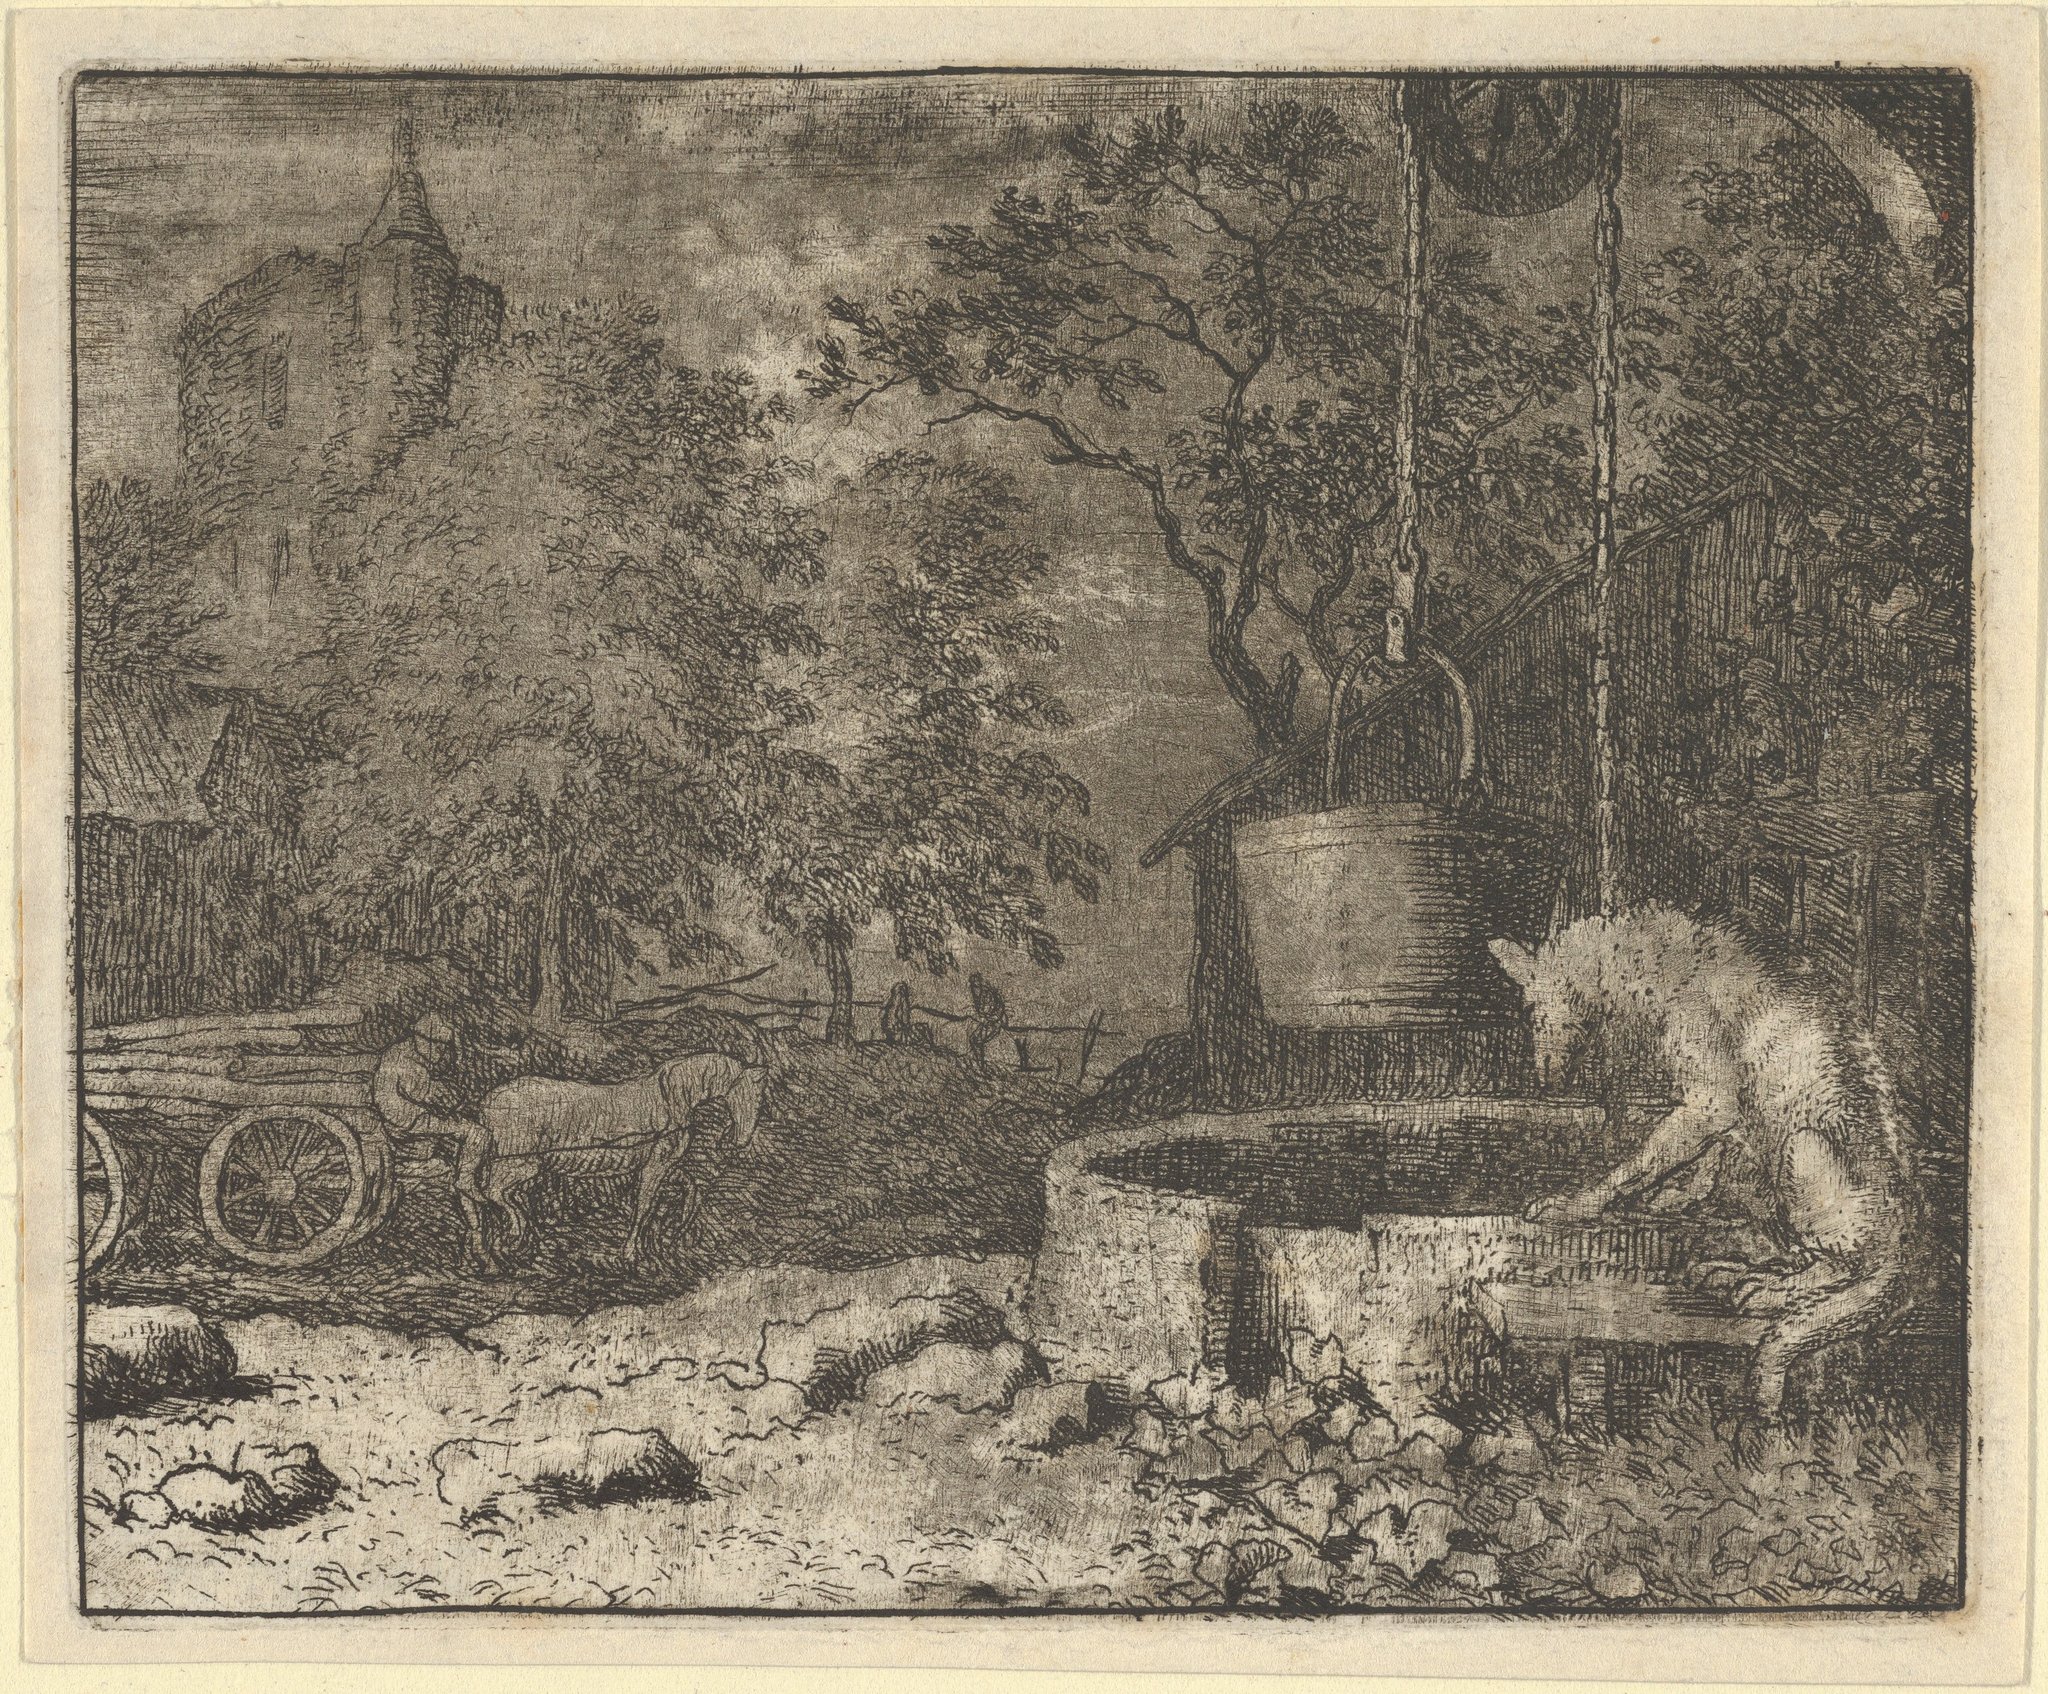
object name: print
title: Renard Plays Another Trick on the She-Wolf from Hendrick van Alcmar's Renard The Fox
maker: allart van everdingen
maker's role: artist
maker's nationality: dutch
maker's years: 1621-1675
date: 1650-1675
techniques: engraving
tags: wells,foxes,horses,trees,carriages